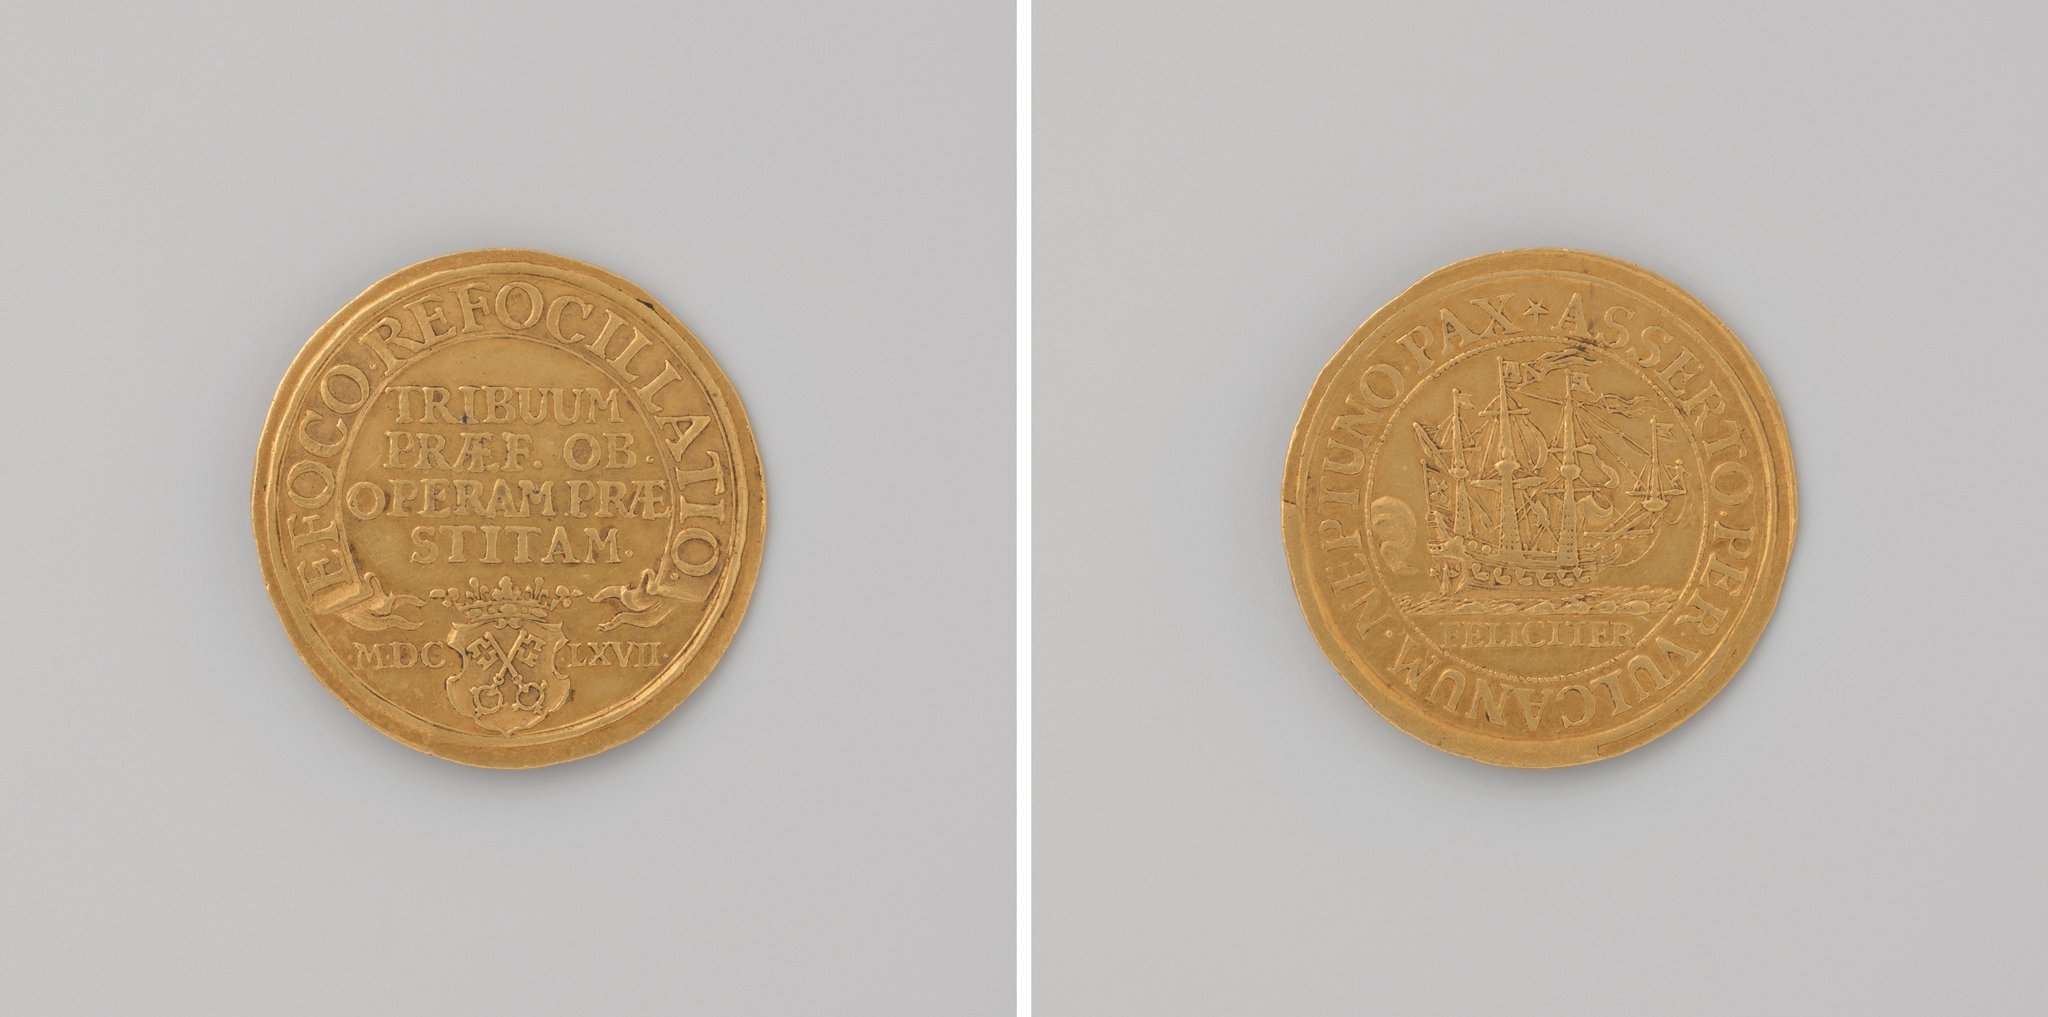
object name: history medal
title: Vrede van Breda, aan de wijkmeesters van Leiden wegens het beschrijven der haardsteden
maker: arent schmeltzing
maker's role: medailleur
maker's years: -1710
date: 1667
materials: gold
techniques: striking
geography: leiden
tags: leiden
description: Gouden penning. Voorzijde: opschrift boven gekroond wapenschild binnen omschrift. Keerzijde: schip boven opschrift binnen omschrift